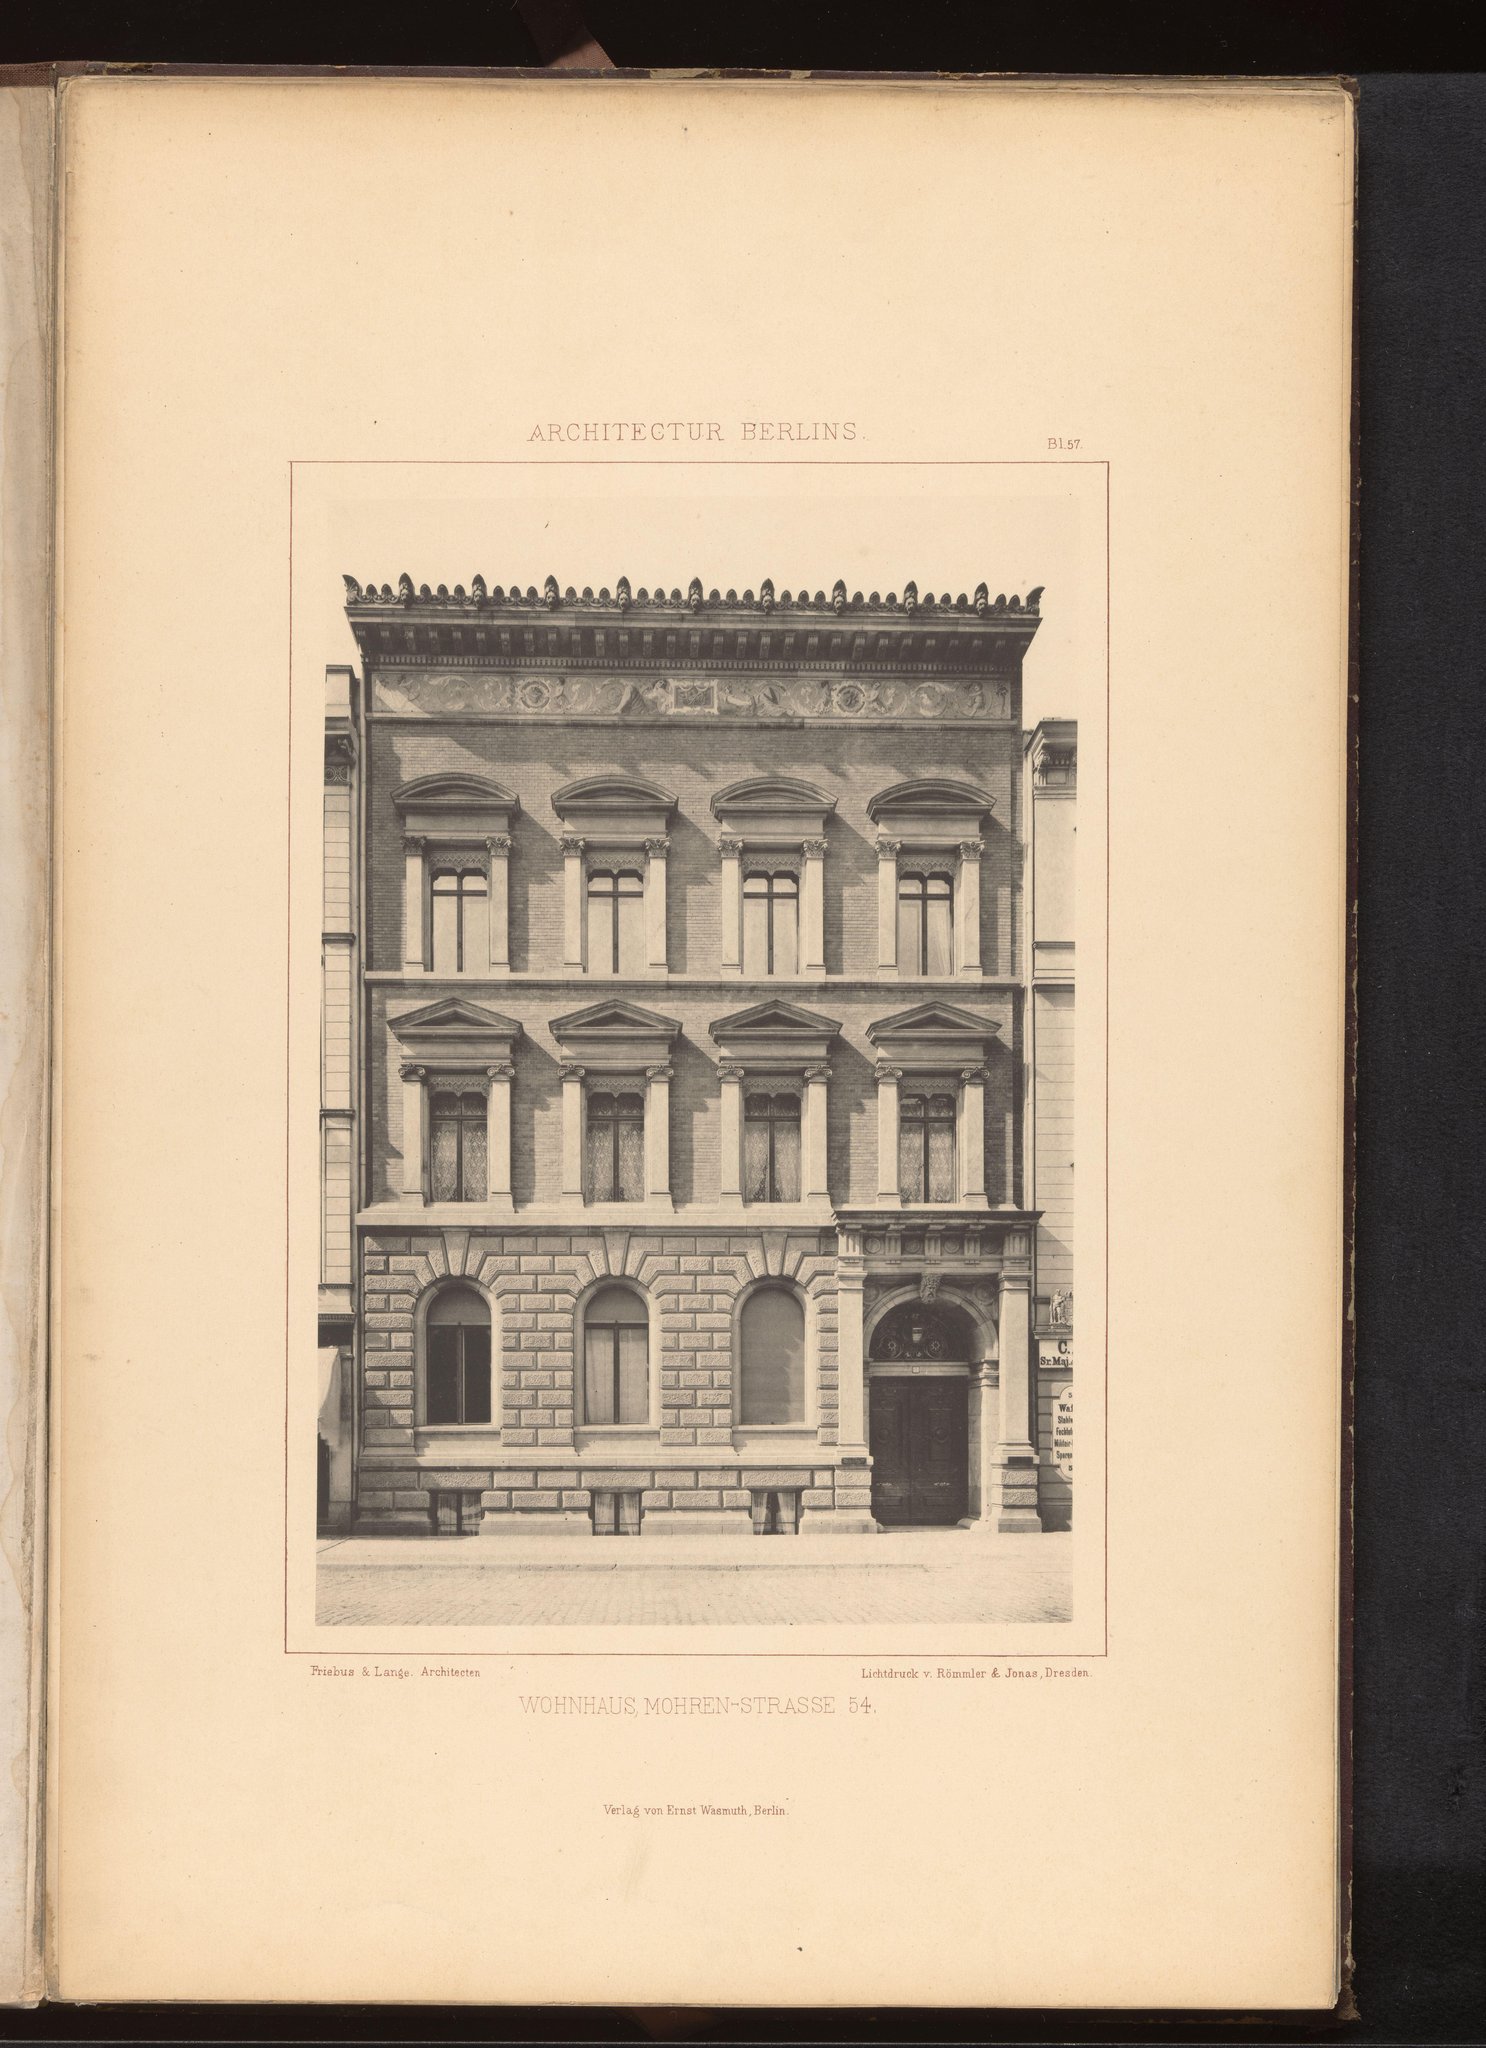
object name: photomechanical print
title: Architectur Berlins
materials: paper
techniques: photograph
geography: berlin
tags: urban housing, berlin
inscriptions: inscription: ‘Friebus & Lange. Architecten.’, number: ‘Bl. 57.’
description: Deze prent maakt deel uit van een omslag met honderd prenten en zes tekstbladen.